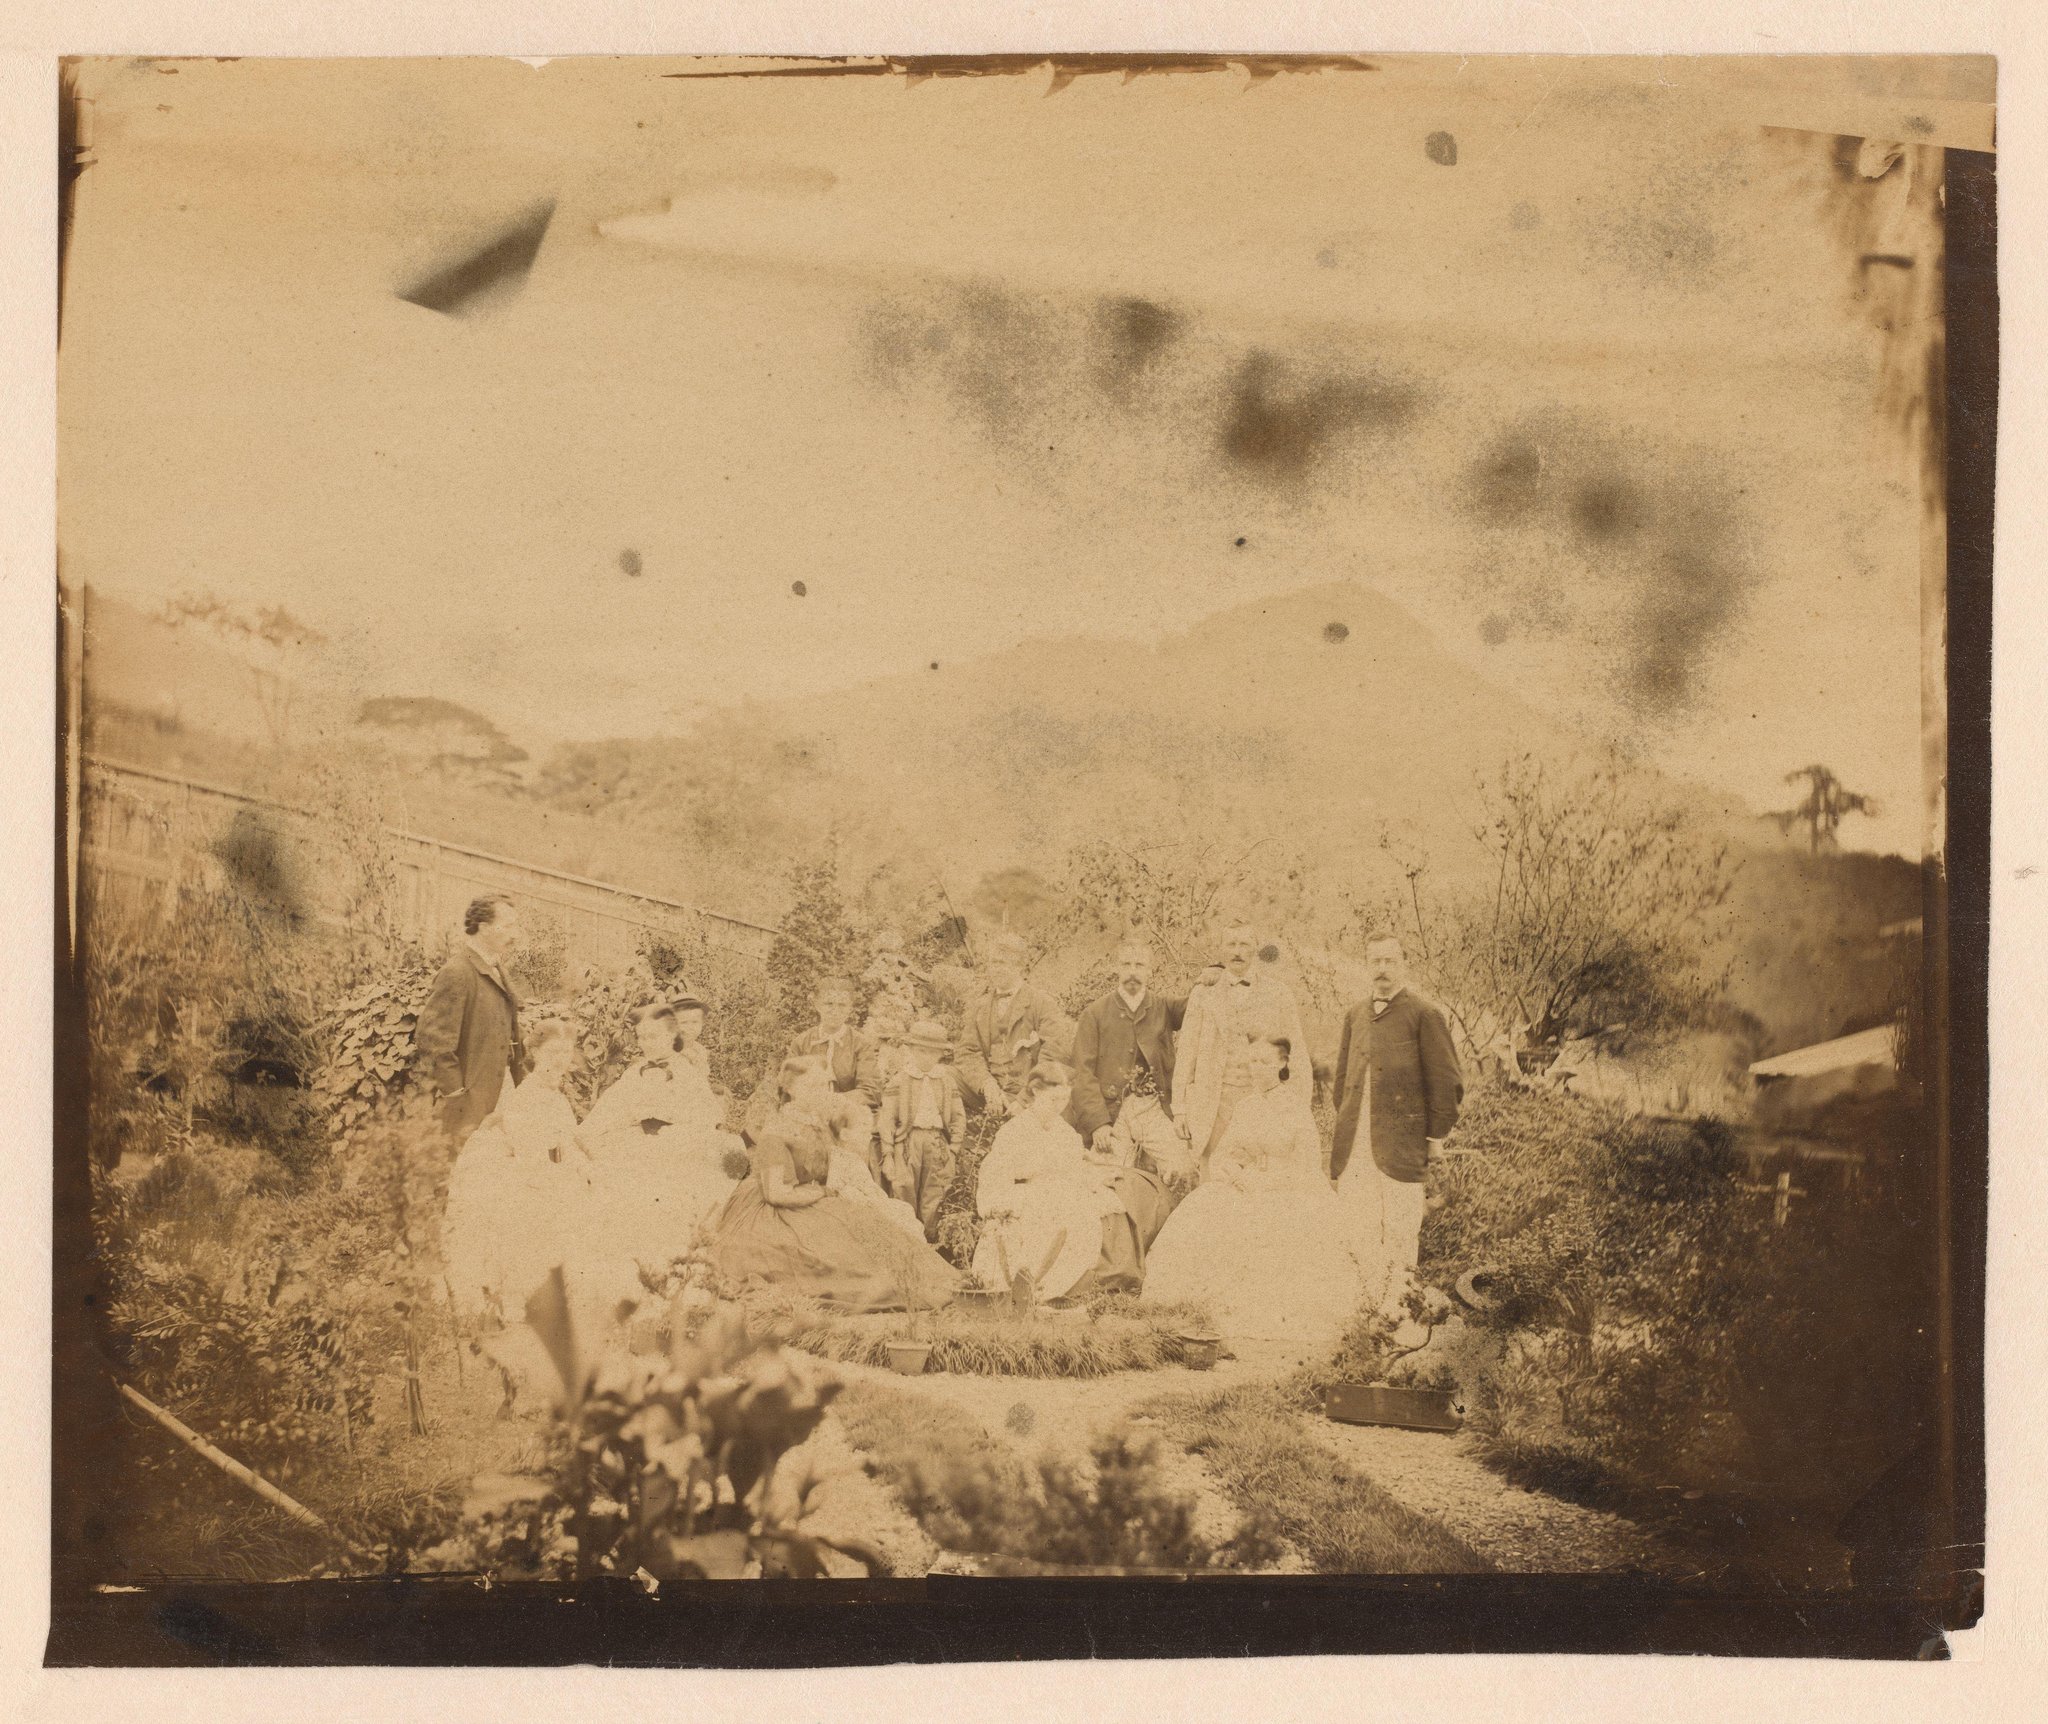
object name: photograph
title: Groepsportret bij het huis van Thomas Glover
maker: antoon bauduin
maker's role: amateurfotograaf, hoogleraar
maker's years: 1820-1885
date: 1862-1866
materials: paper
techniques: albumen print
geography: japan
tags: anonymous historical persons portrayed in a group, in a group-portrait, japan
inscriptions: number: ‘151’